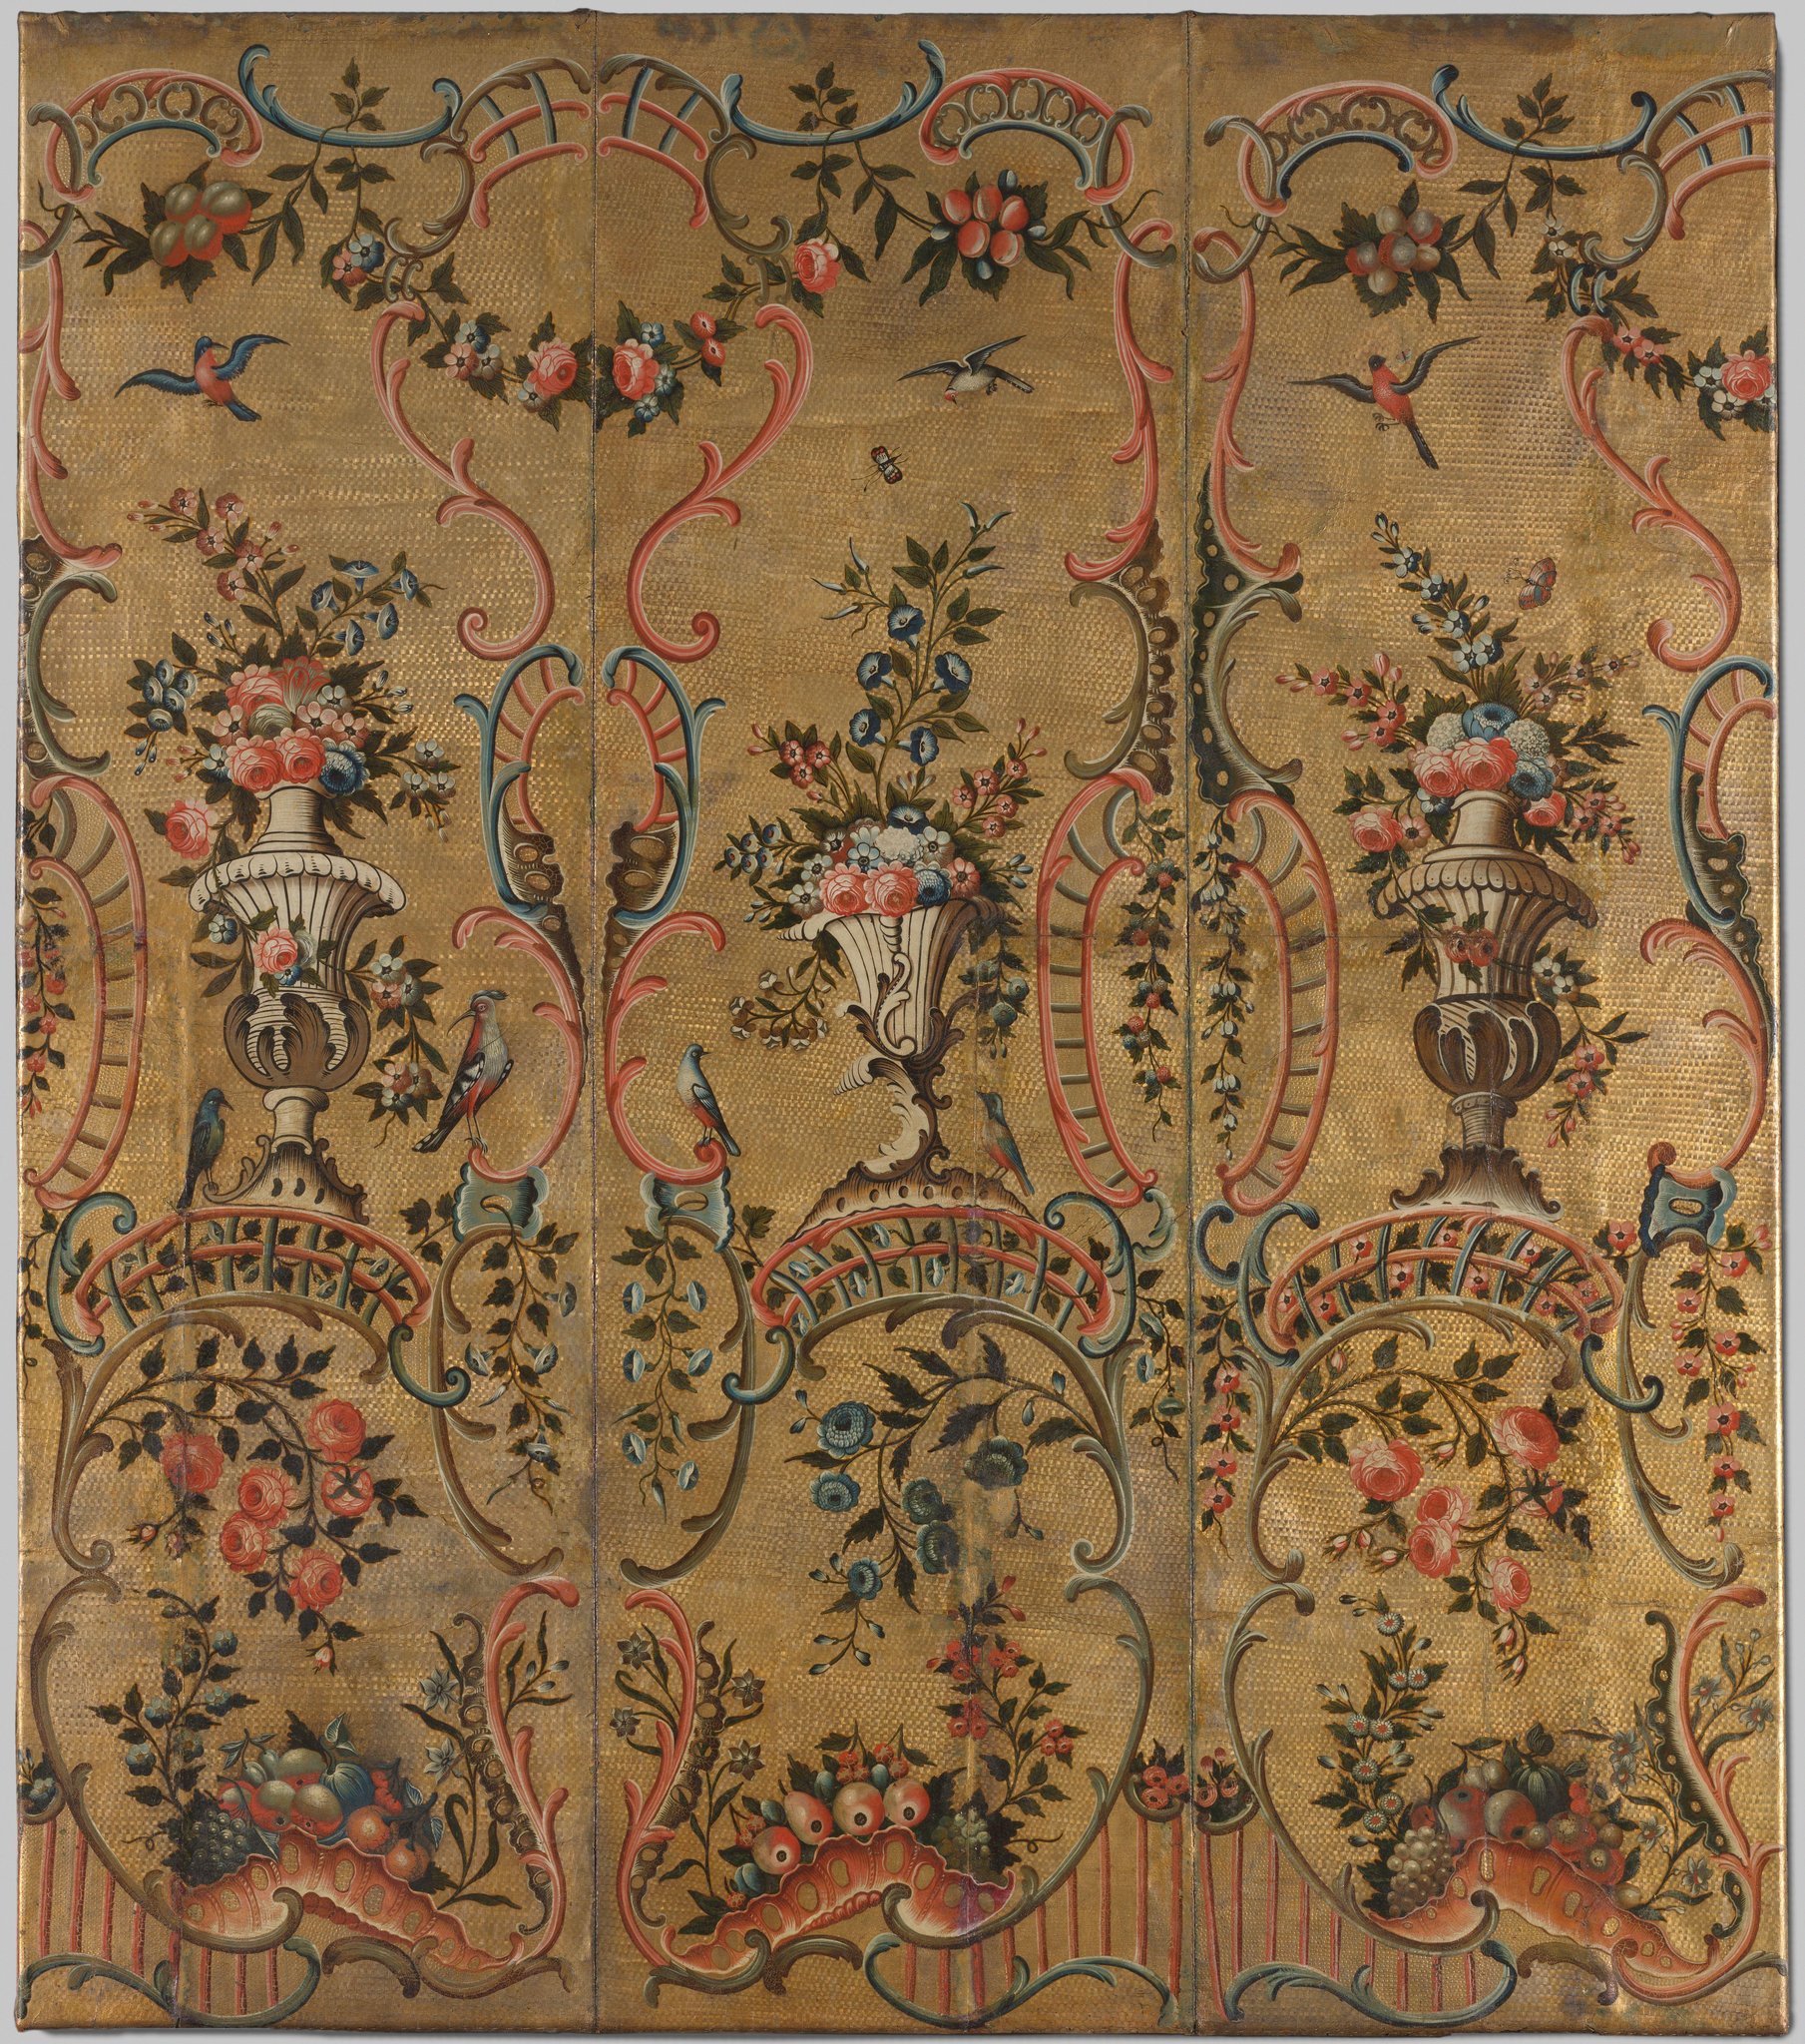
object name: gilt leather hanging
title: Paneel met drie banen goudleer, verguld geponst fond met beschildering van omramingen van rocailles en S- en C-voluten waarbinnen bloemenvazen, bloem- en vruchtentakken en -slingers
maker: Anonymous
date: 1750-1775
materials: gilt leather, leather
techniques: painted, punching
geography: northern netherlands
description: Het vergulde geponste fond is beschilderd met omramingen van rocailles en S- en C-voluten, waarbinnen bloemenvazen. Onderaan zijn nog vruchten en bloemtakken en bovenaan vruchten en bloemslingers met vogels aangebracht. De beschildering is uitgevoerd in verschillende tinten grijs, rood, groen en blauw.